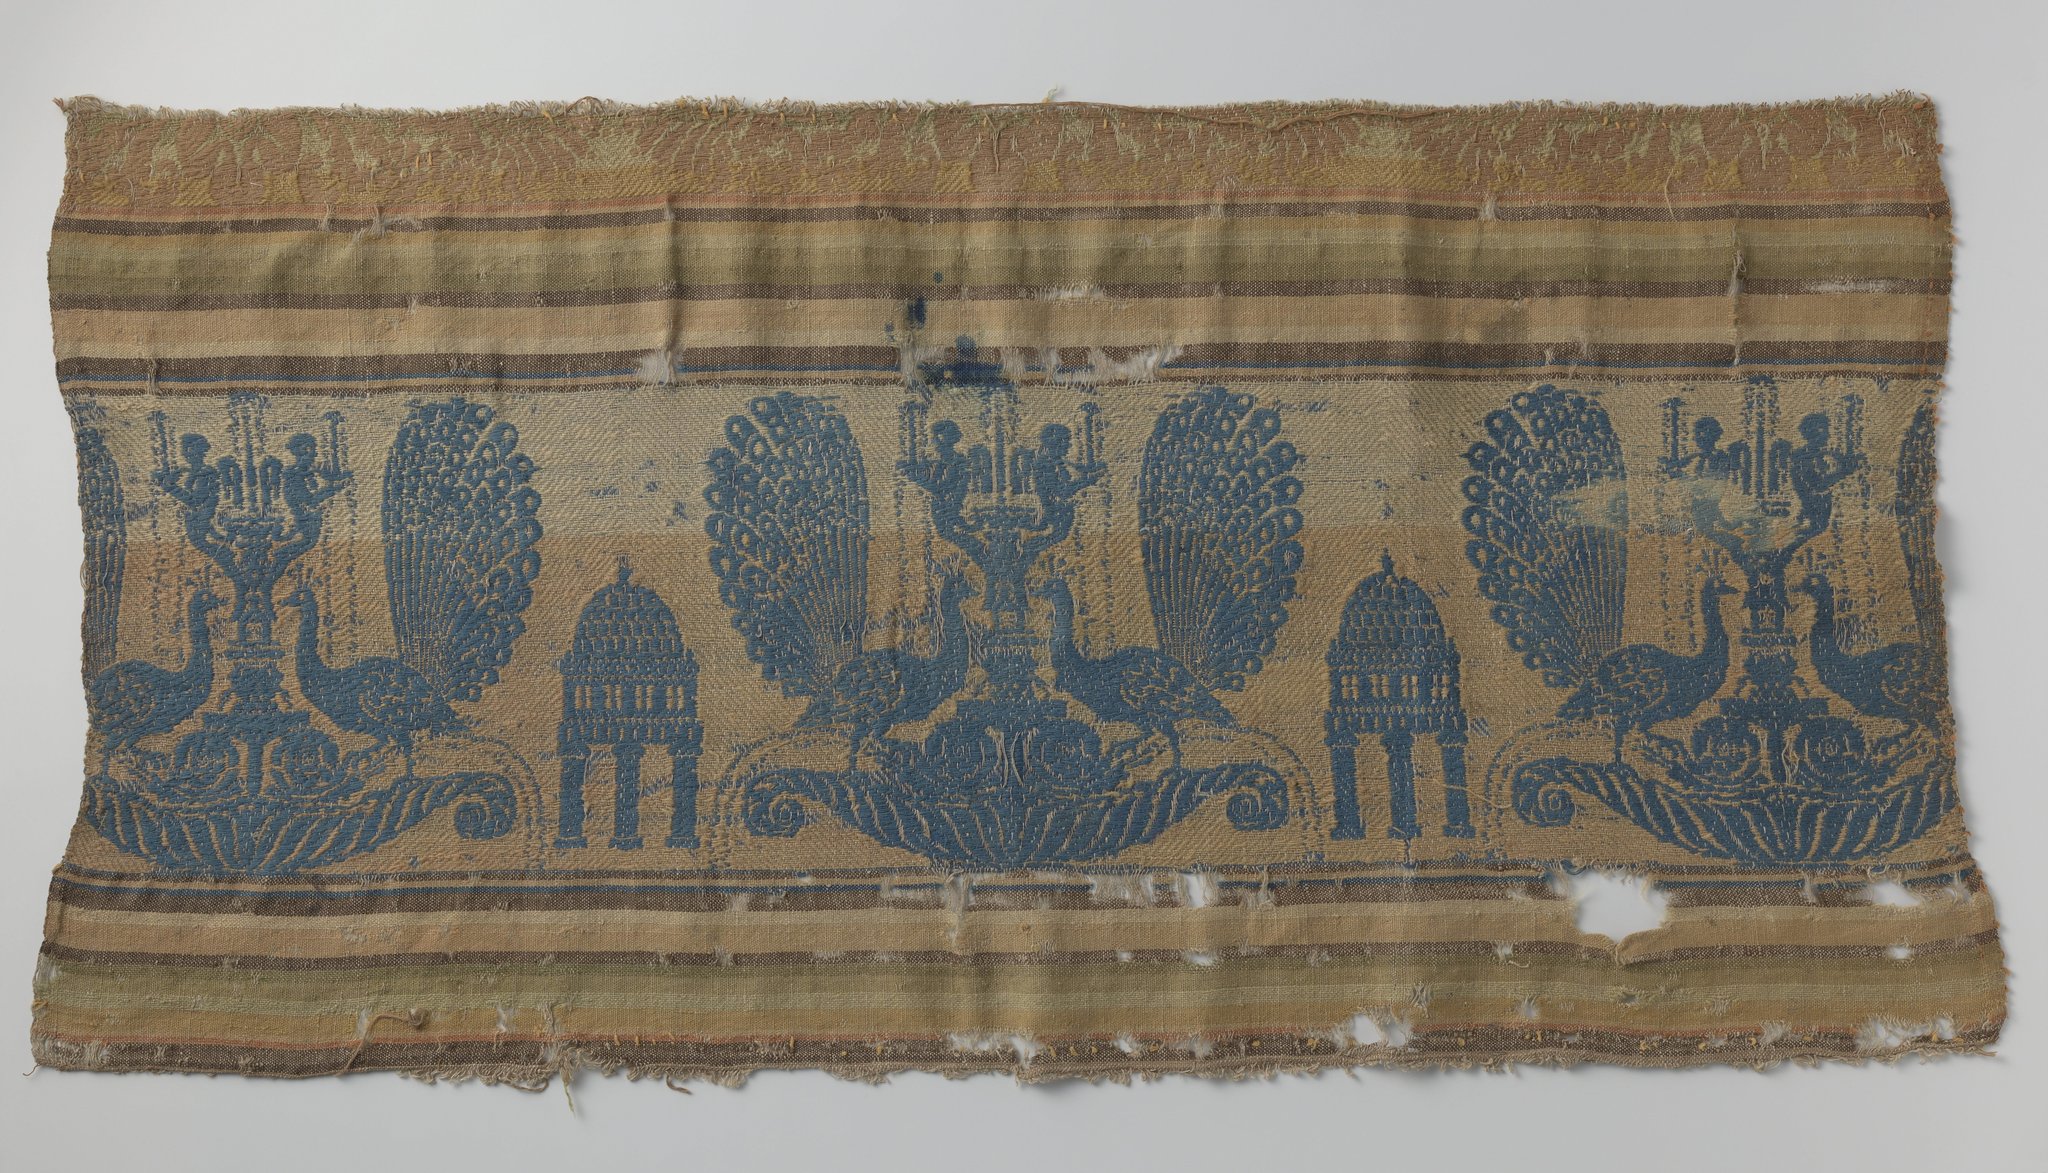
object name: woven material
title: Fragment wollen weefsel met symmetrisch motief van pauwen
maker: Anonymous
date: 1400-1499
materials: cotton, wool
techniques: double weave, weave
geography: italy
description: Fragment met een zich herhalend patroon in blauw en oker van naar elkaar toegewende pauwen die op een schelpvormig bassin staan met een ornament met o.a. putti. Deze pauwengroepjes worden afgewisseld door een koepelbouwwerk. Langs de randen een streepdessin in wit, geel, bruin, blauw en groen. Van dit fragment is een stuk met eenzelfde patroon, maar in de kleuren geel, bruin en groen, afgeknipt (BK-1955-105-B).